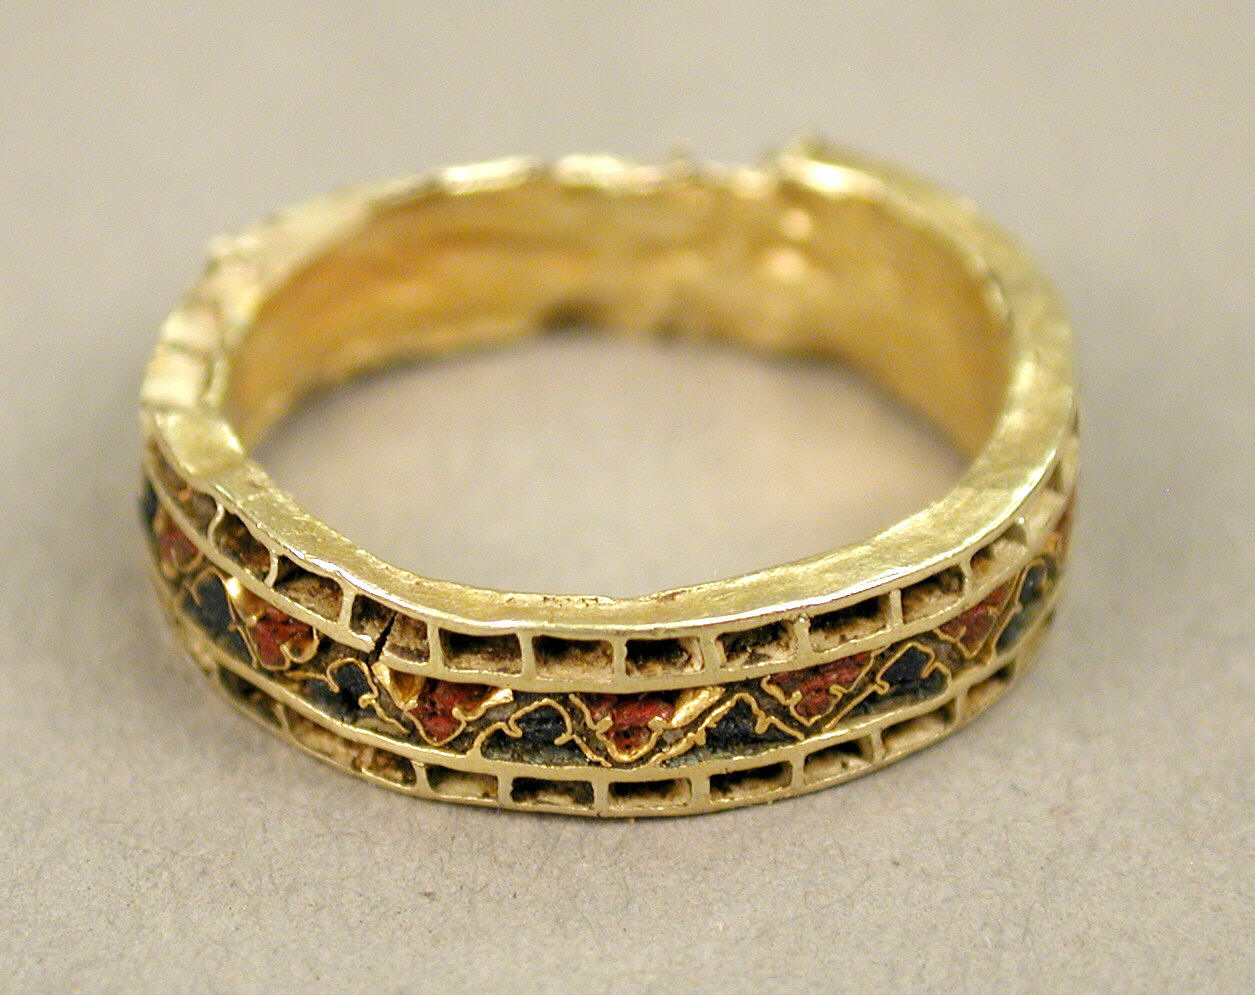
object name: ring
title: Circular Fragment with a Vine Scroll Motif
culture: byzantine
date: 1000-1100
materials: enamel, gold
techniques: enamel